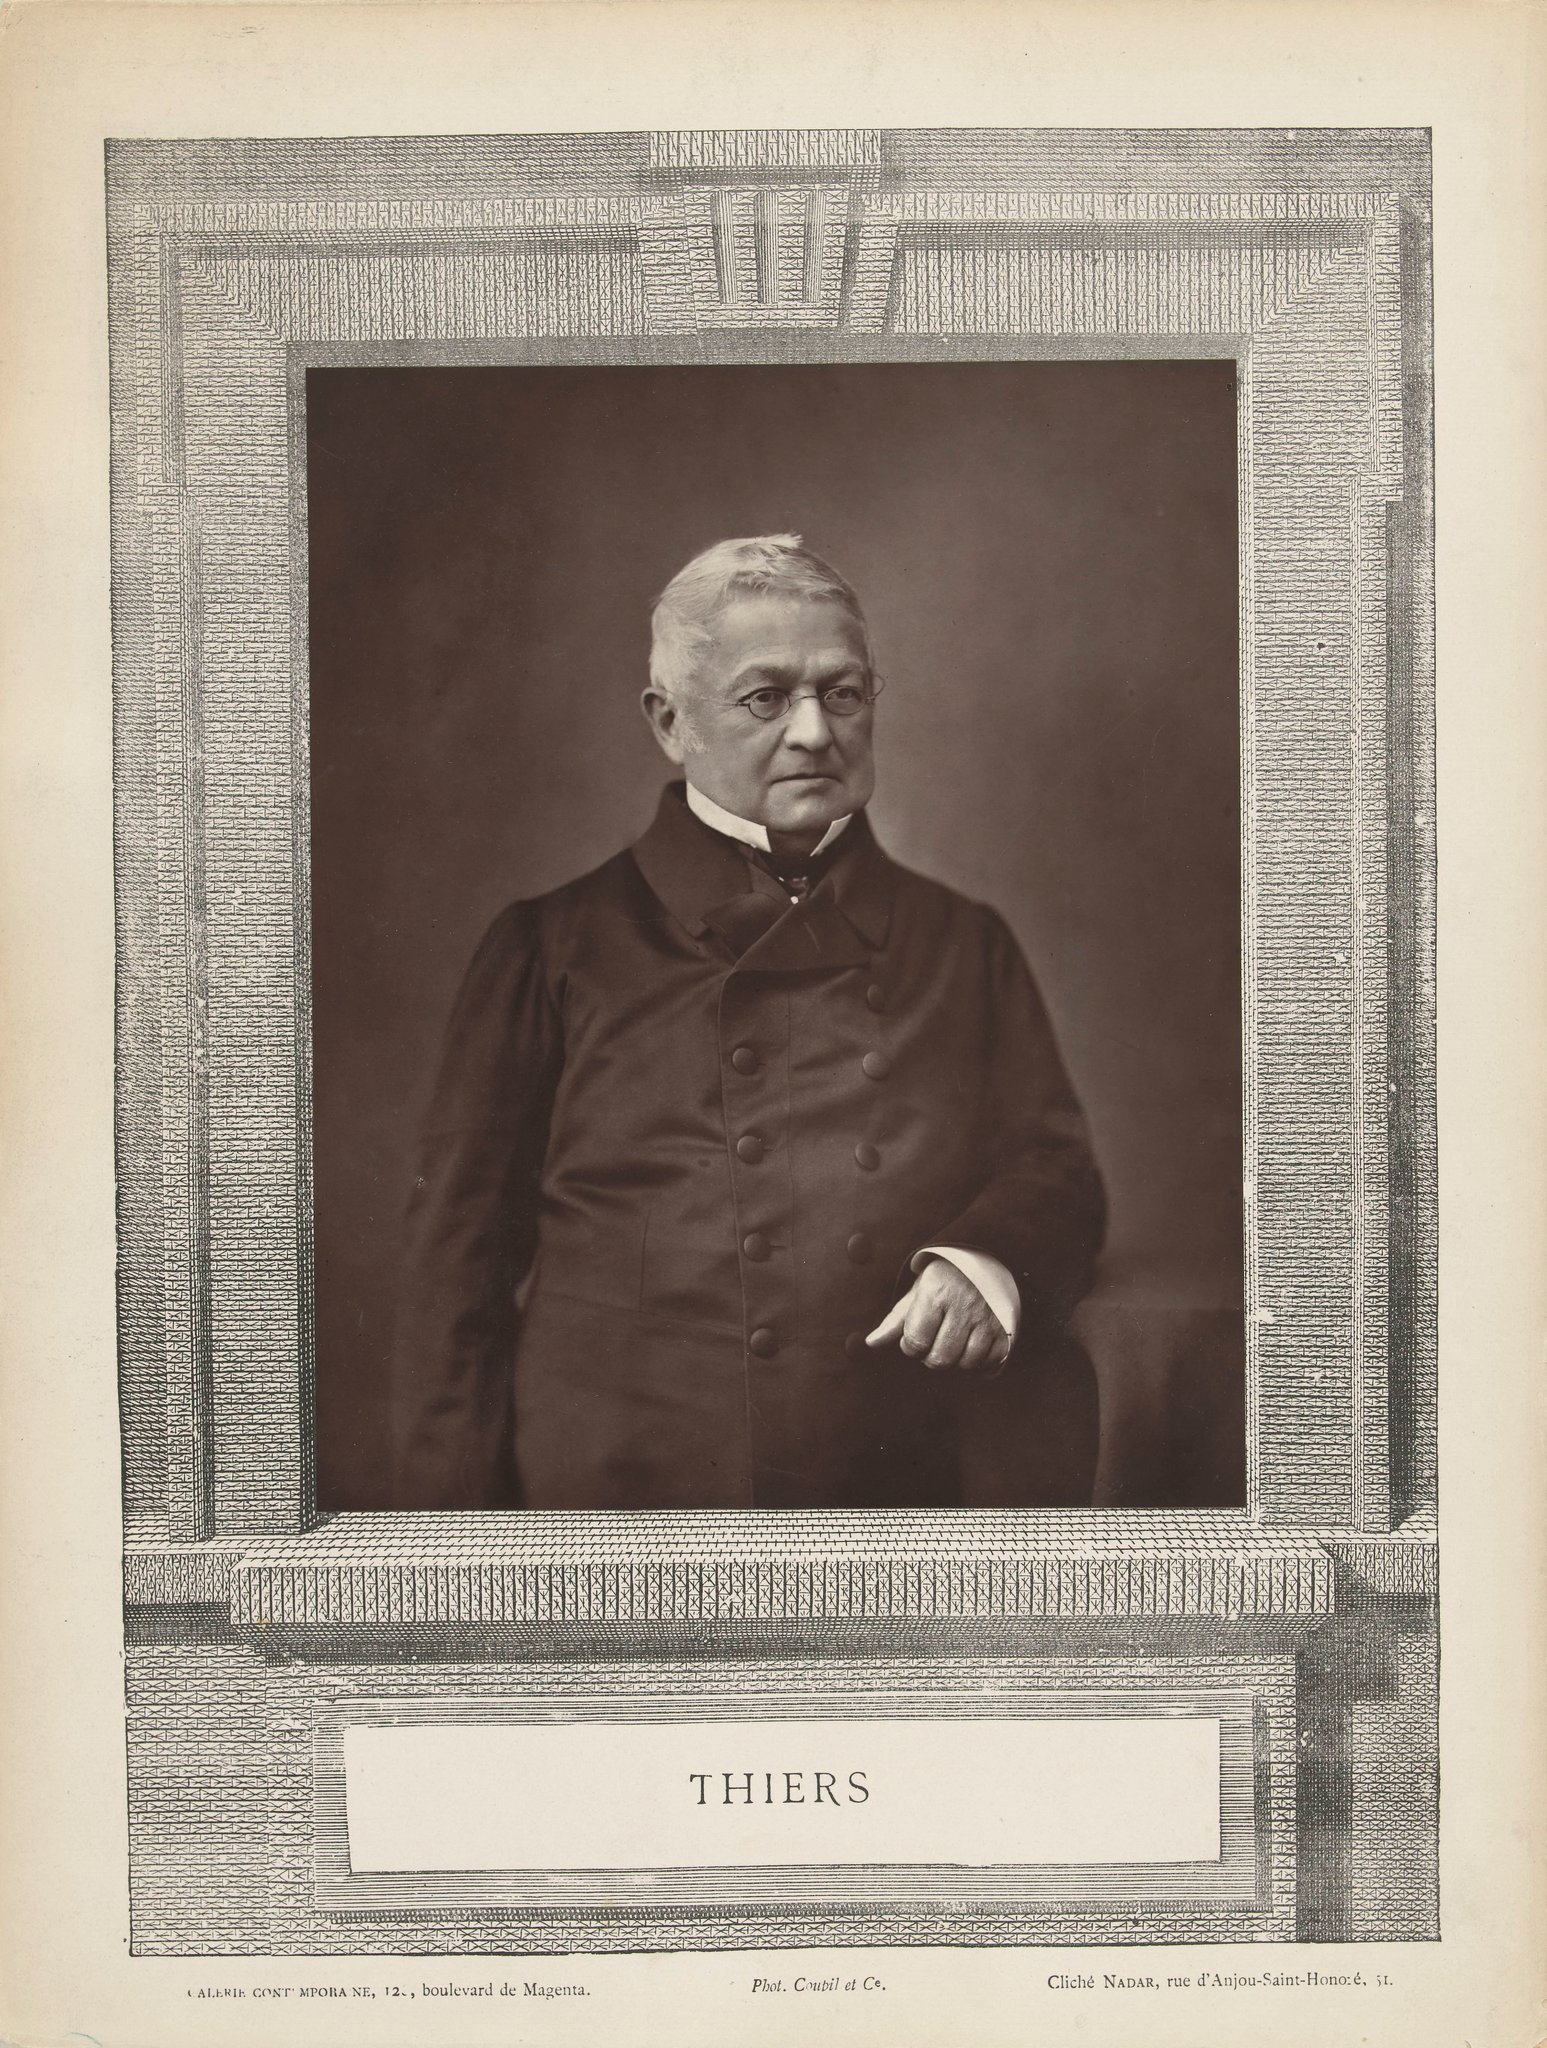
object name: photomechanical print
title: Thiers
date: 1867-1877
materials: cardboard, paper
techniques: woodburytype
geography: paris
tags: marseille, politician, adult man, historical persons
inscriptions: address: ‘GALERIE CONTEMPORAINE, 126, boulevard de Magenta.’, address: ‘rue d'Anjou-Saint-Honoré, 51.’, number: ‘565[?]/ 200,=’, number: ‘1568’, number: ‘81’